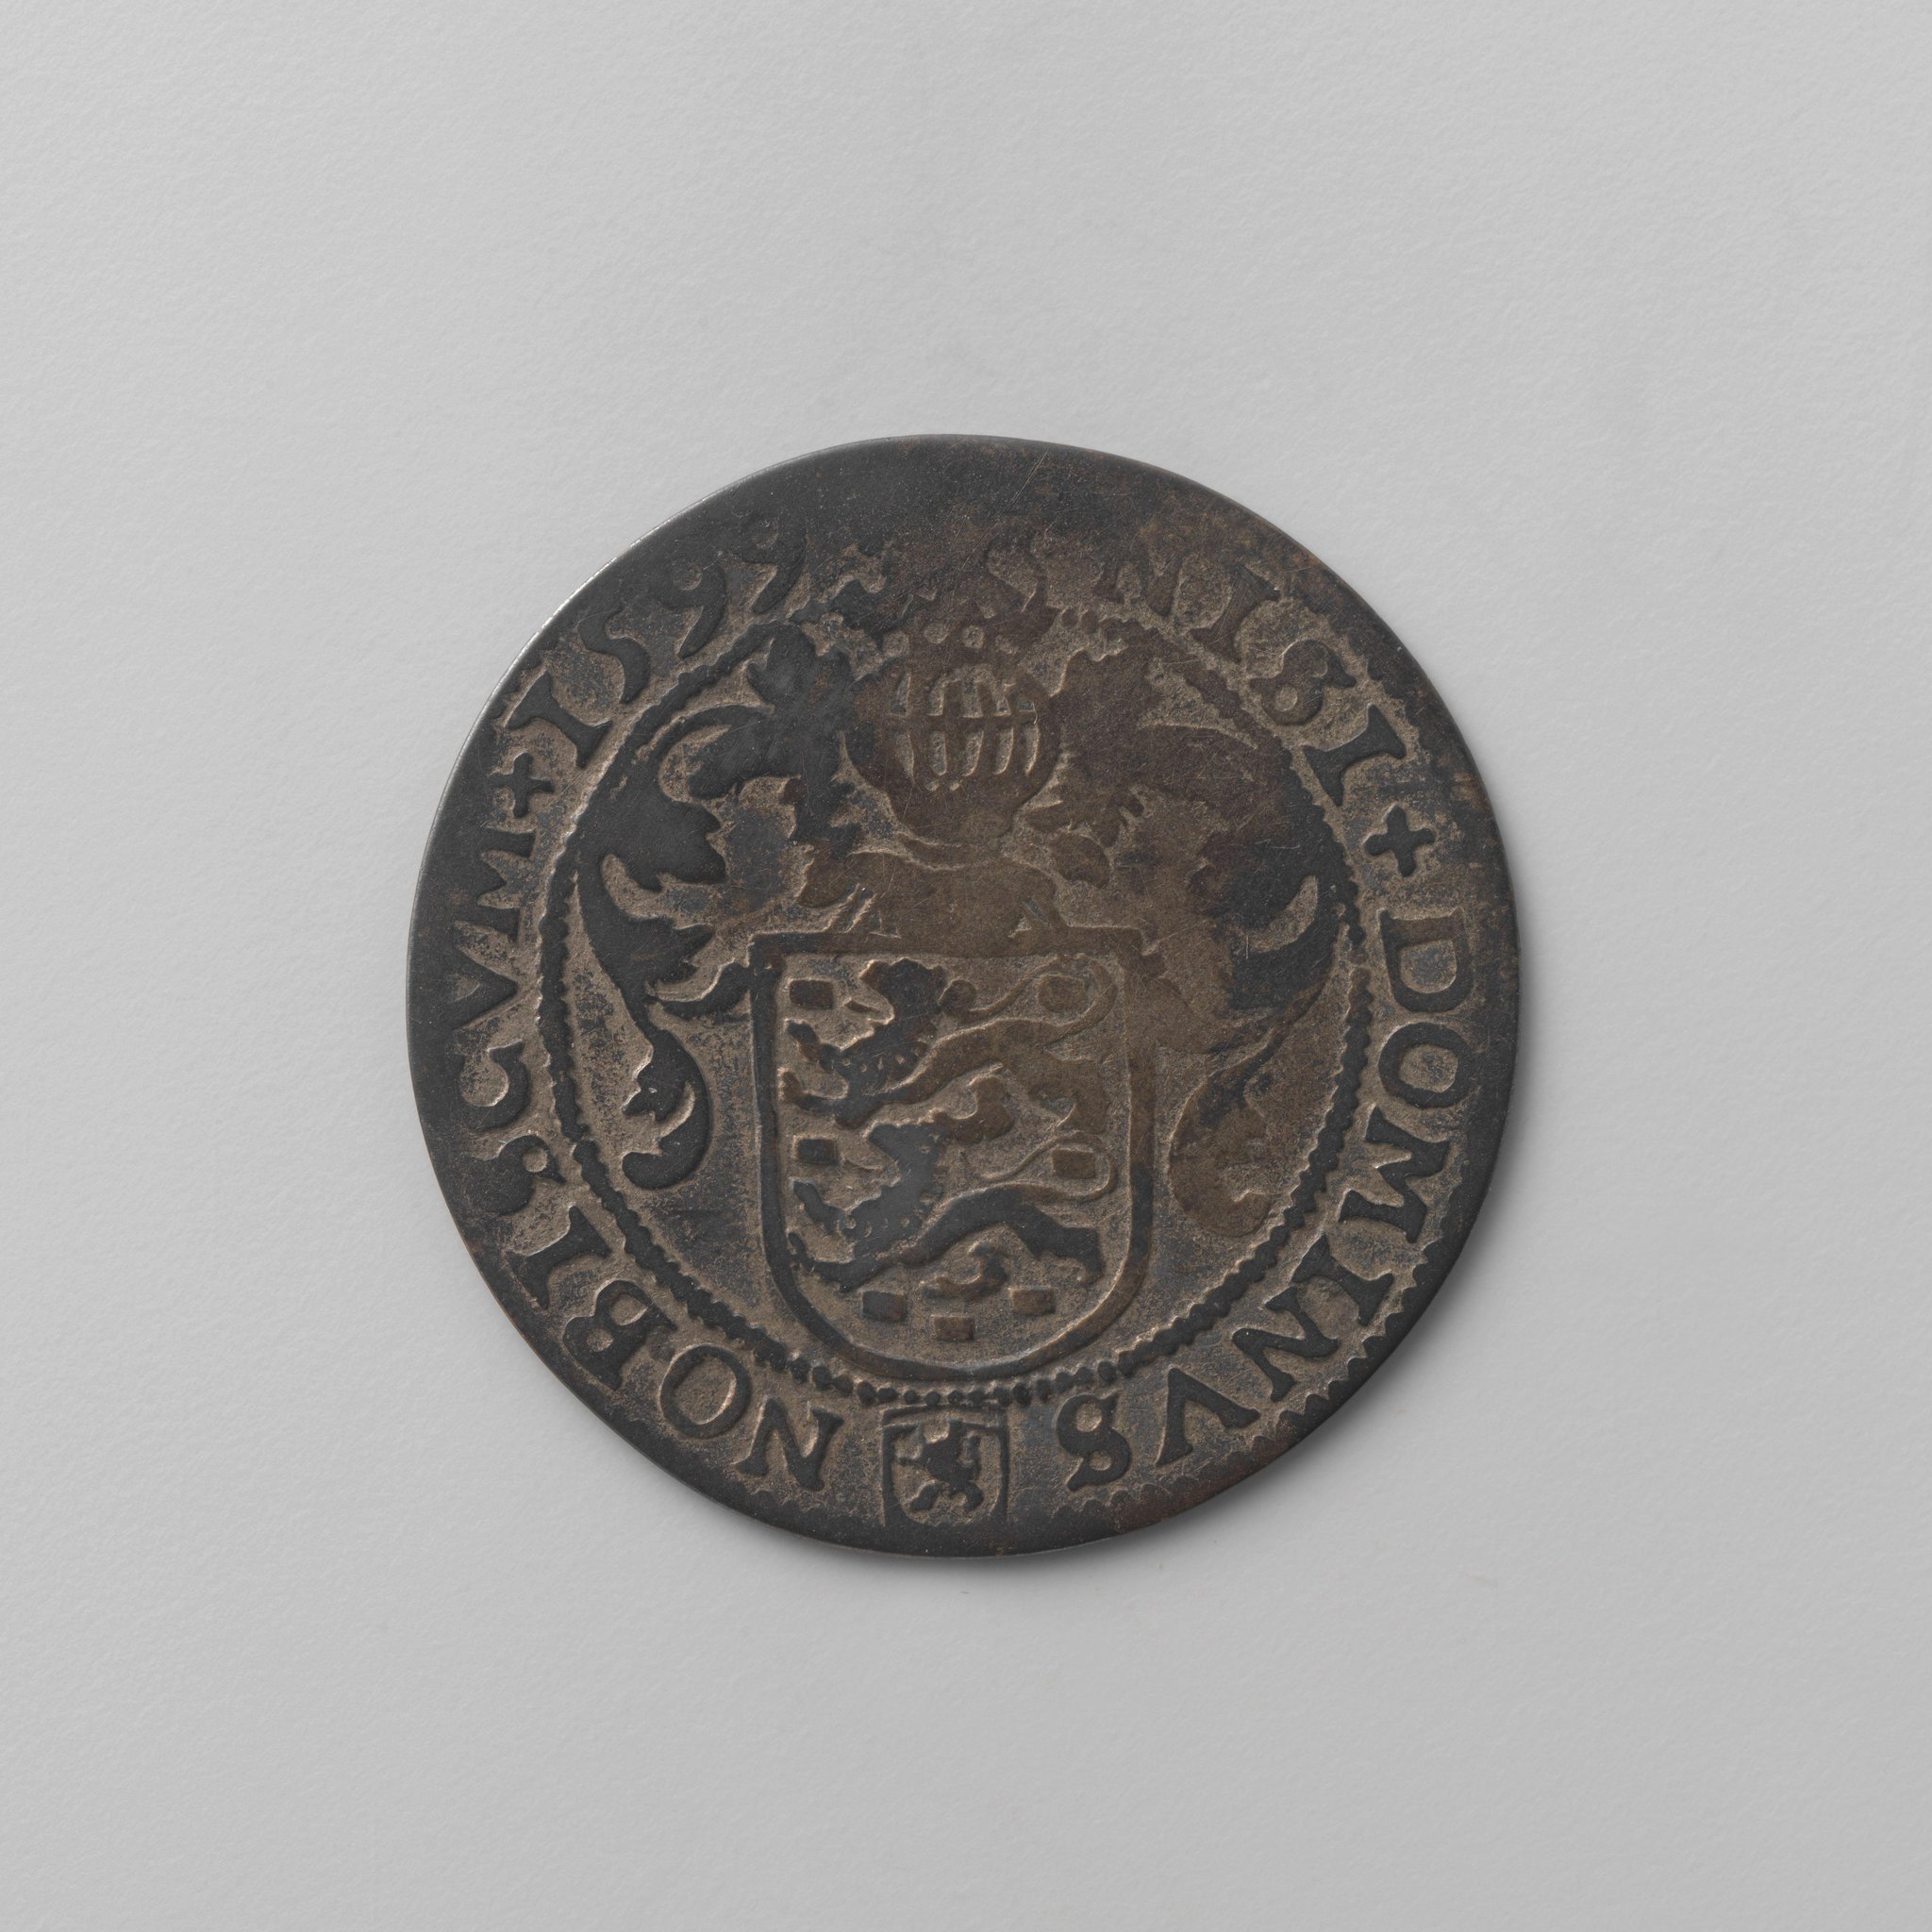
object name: coin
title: Halve gehelmde schelling van Friesland, 1599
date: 1599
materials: silver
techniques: striking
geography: leeuwarden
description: Zilveren munt. Voorzijde: Onder recht naar voren gekeerde helm met helmteken wapenschild van Friesland. Jaartal in omschrift. Keerzijde: op lang gebloemd kruis ongekroond wapenschild van Friesland.